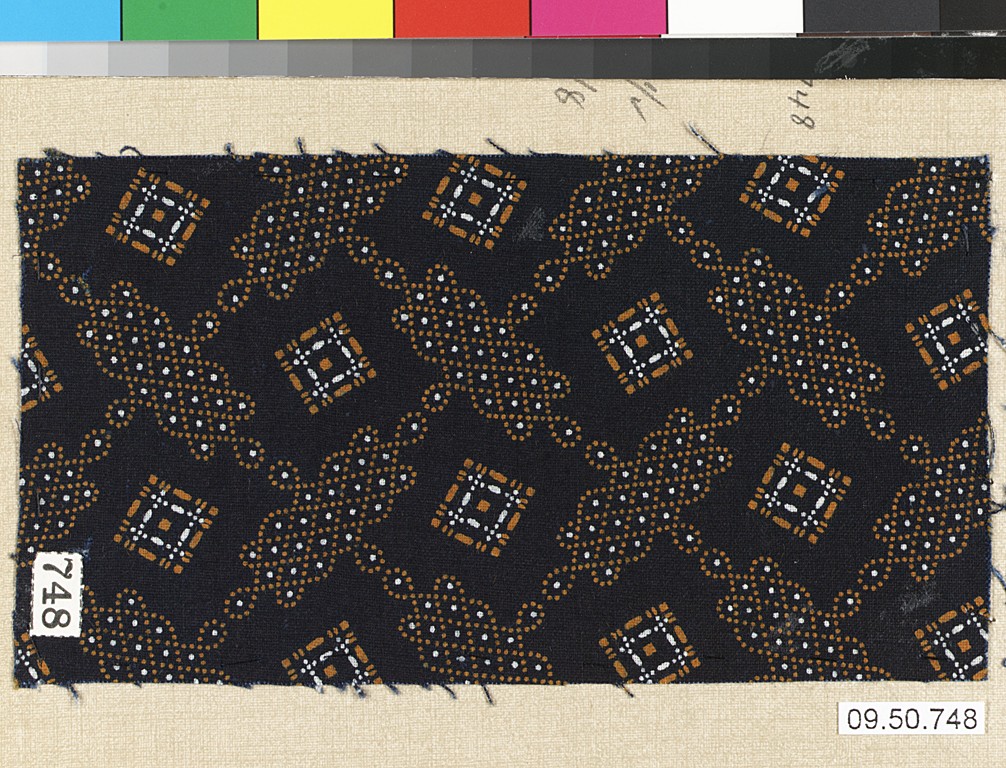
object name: piece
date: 1801-1900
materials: cotton